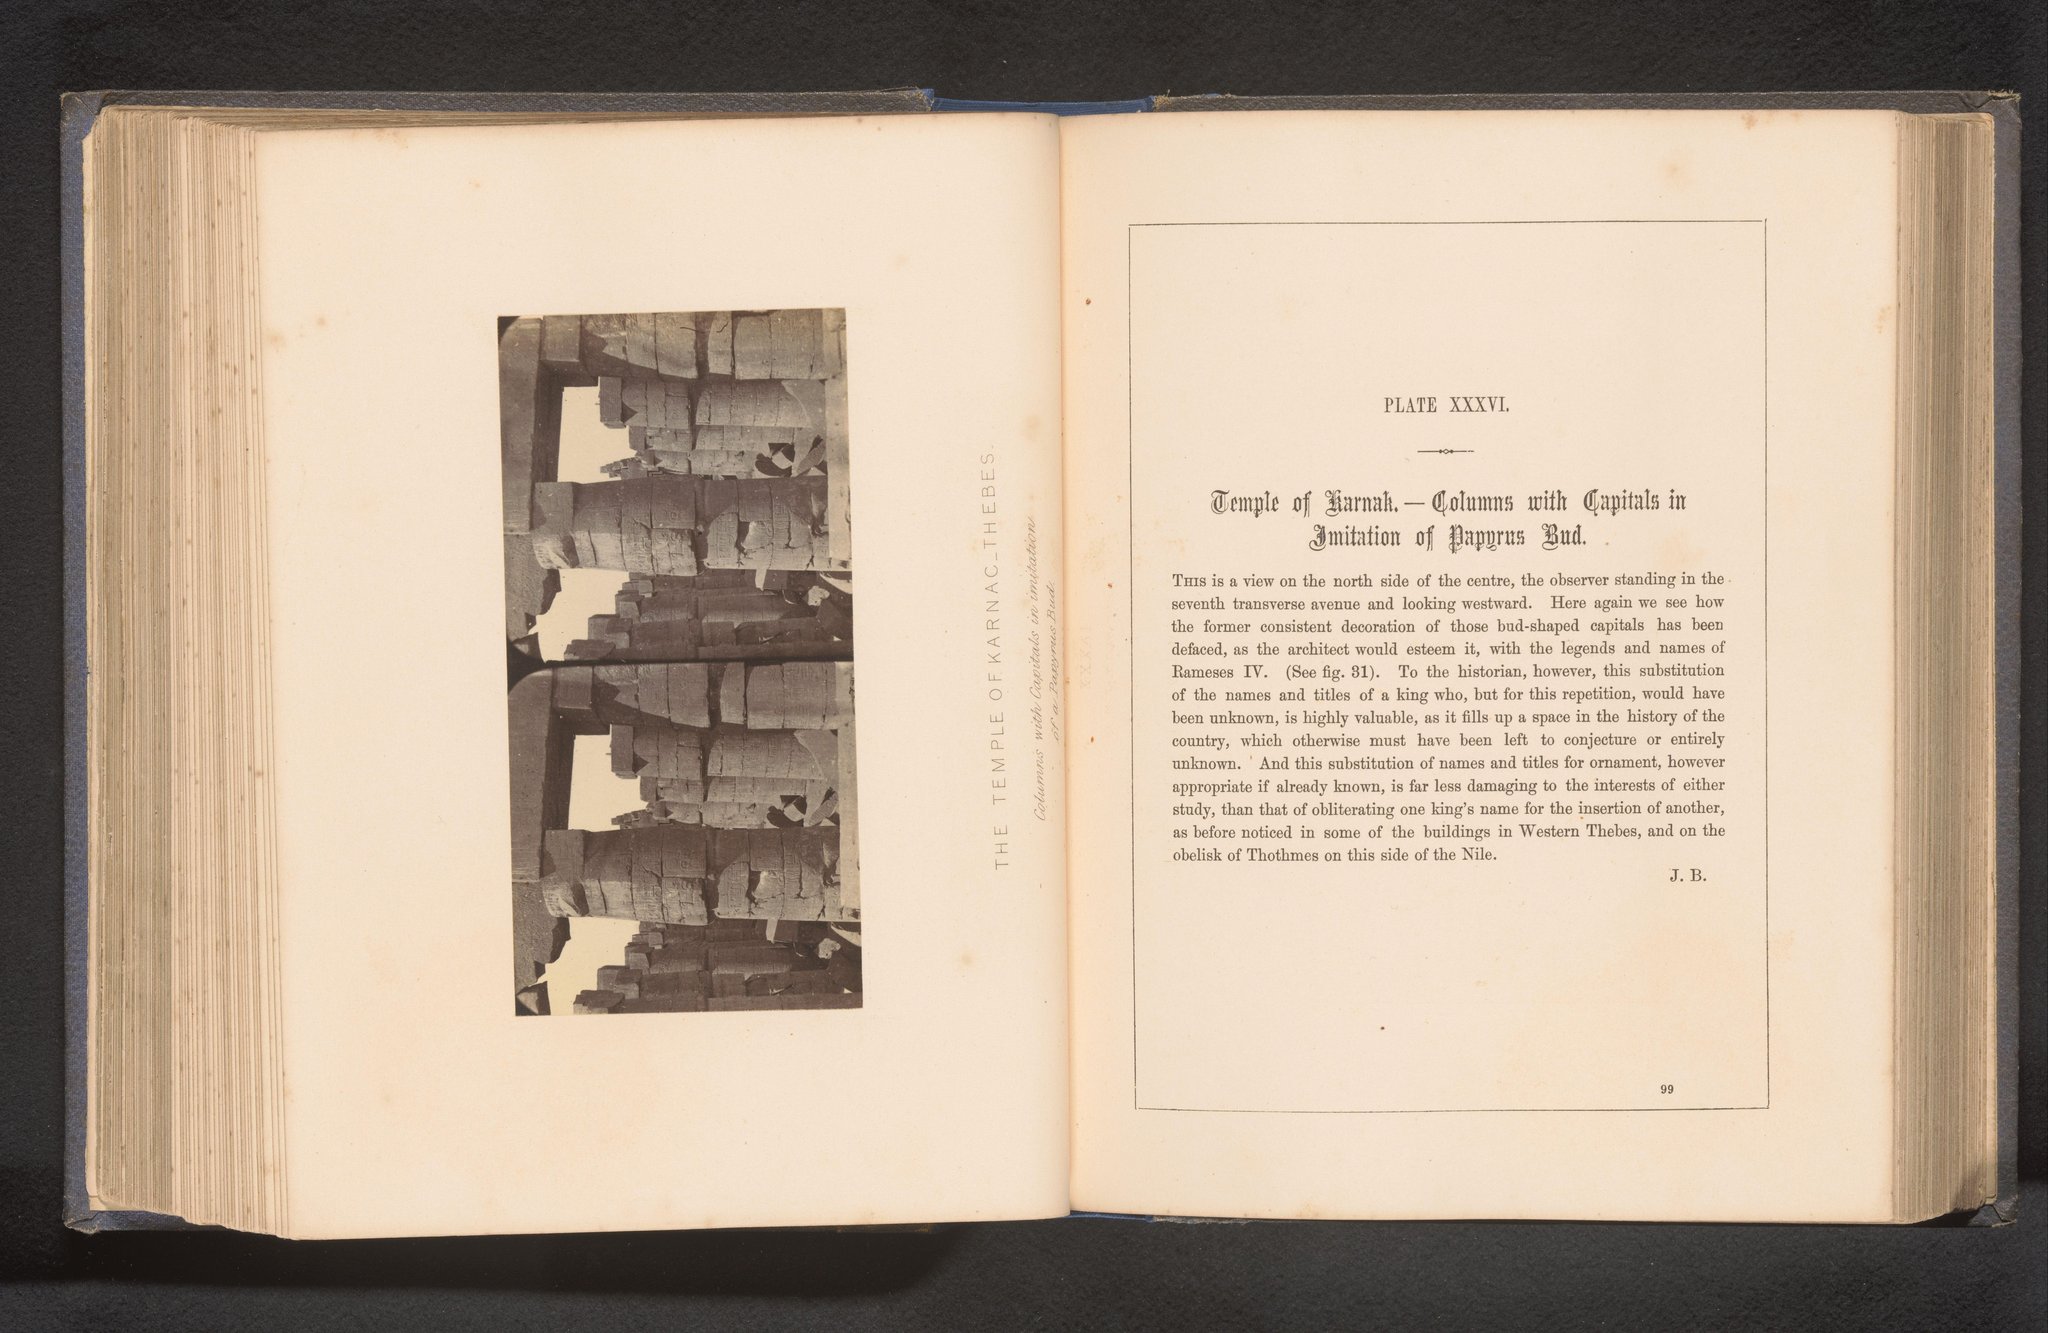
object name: page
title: The temple of Karnak - Thebes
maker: francis frith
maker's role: publisher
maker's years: 1822-1898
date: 1857-1862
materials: photographic support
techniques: albumen print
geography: karnak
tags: column, pillar ~ architecture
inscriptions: number: ‘XXXVI’, name: ‘Frith’, inscription: ‘Columns with Capitals in imitation of a Papyrus Bud’